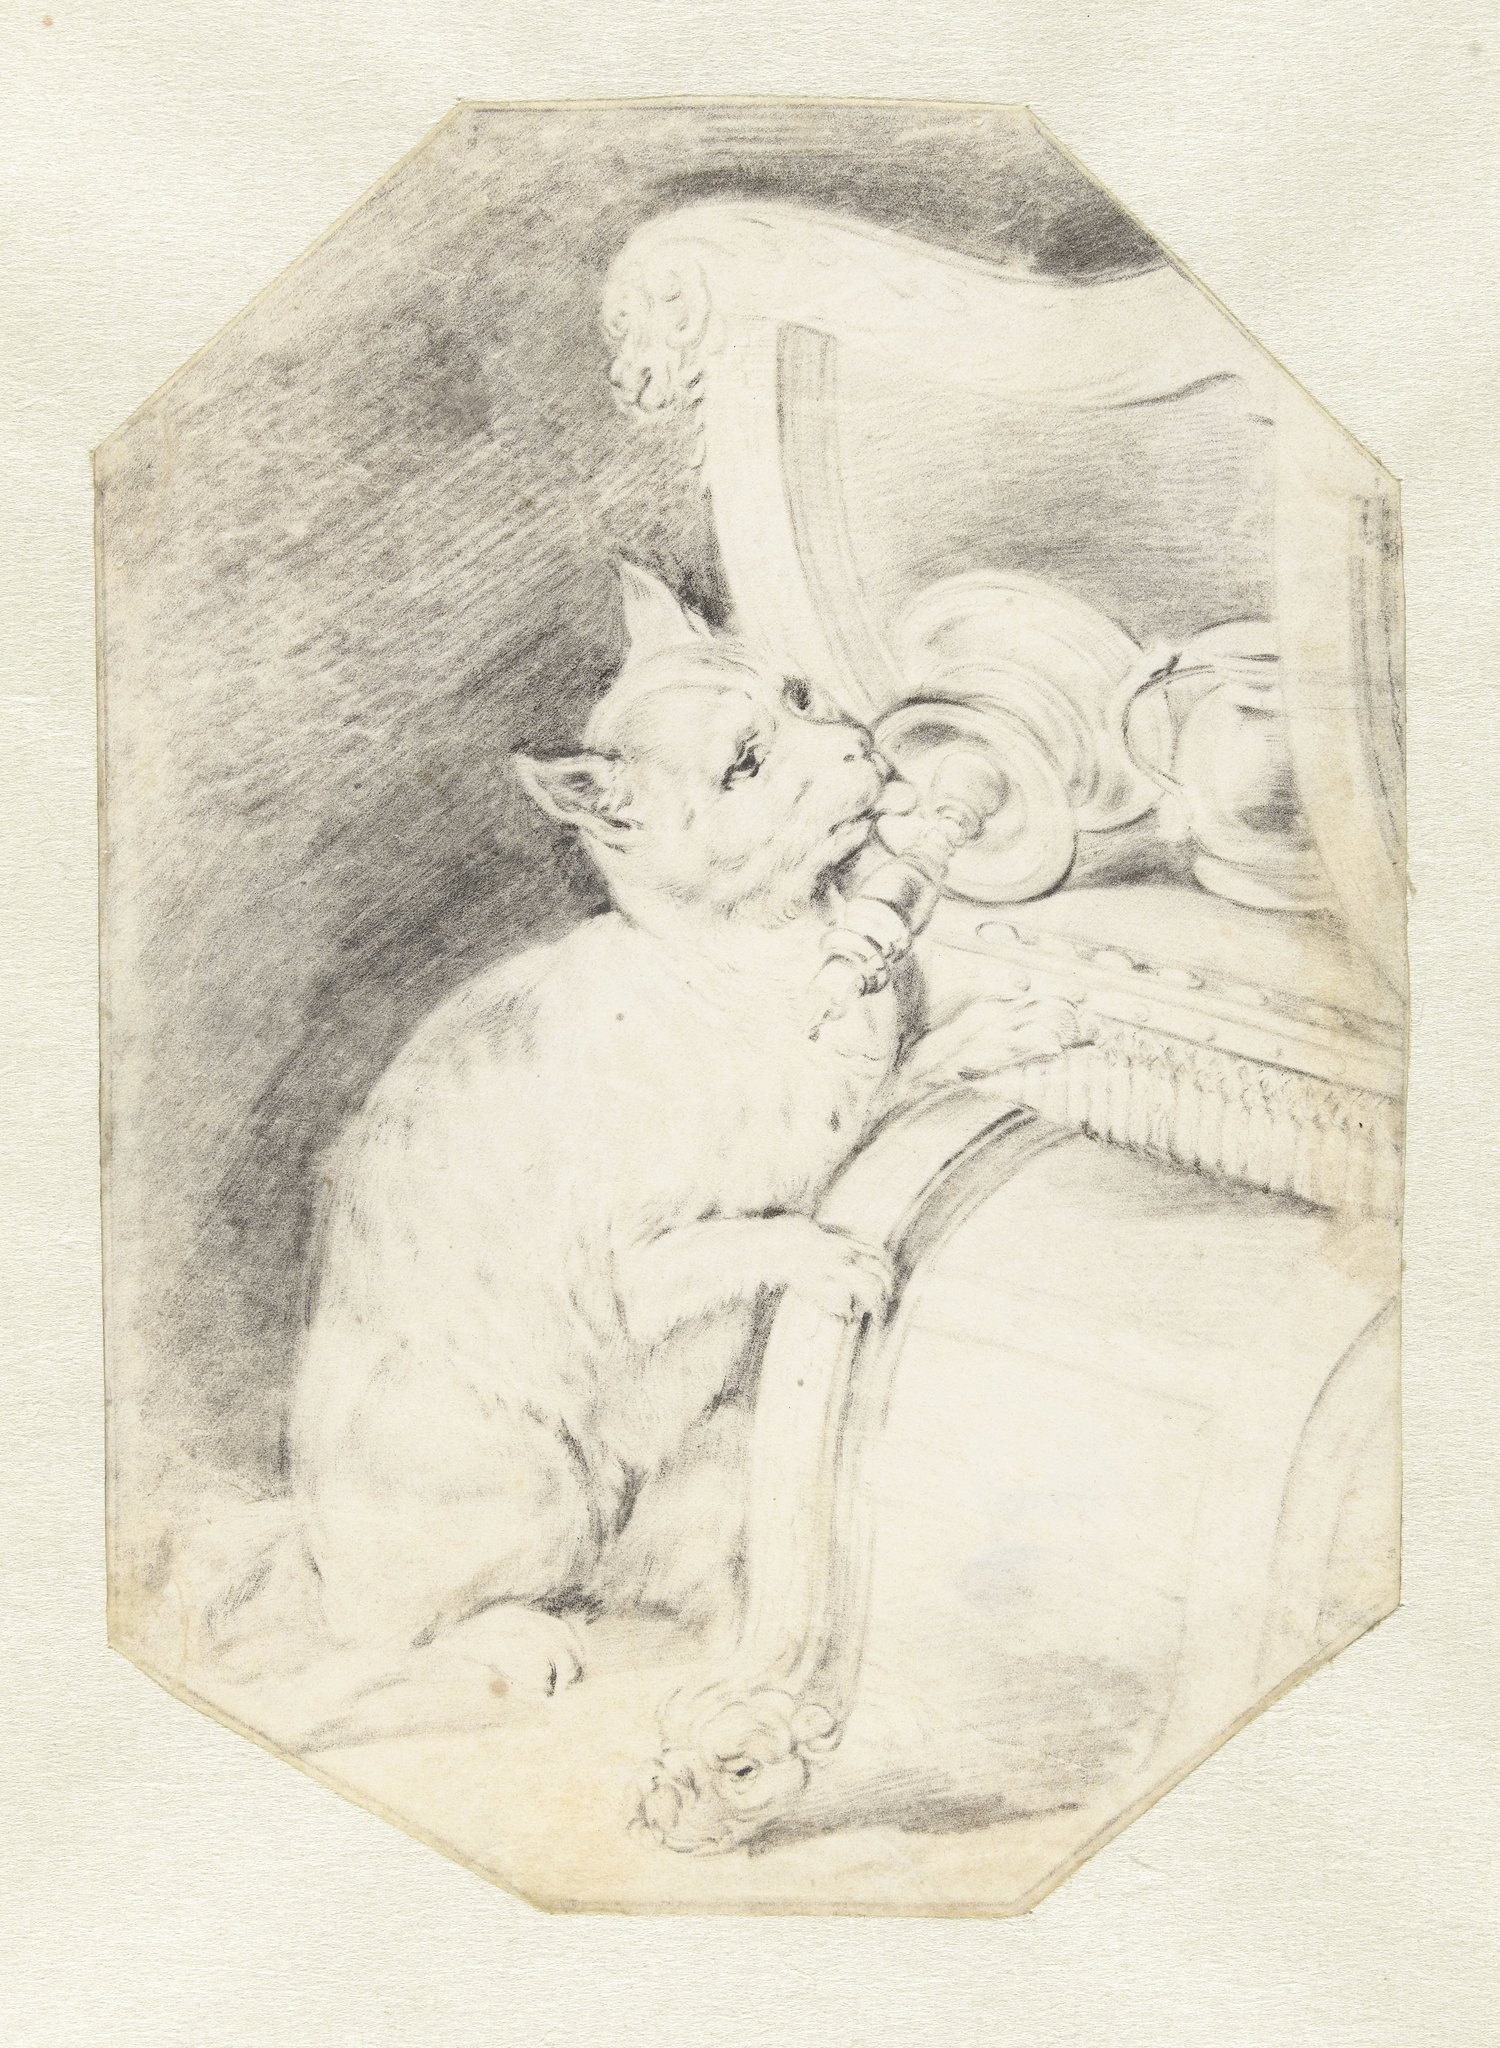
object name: drawing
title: Cat Licking Wax from a Candleholder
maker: cornelis visscher (ii)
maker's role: draughtsman, painter, print maker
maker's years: 1628-1658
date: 1650-1654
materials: chalk, parchment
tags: cat, proverbs, sayings, etc., candlestick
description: Verbeelding van het spreekwoord 'Om der wille van het smeer likt de kat de kandeleer'.